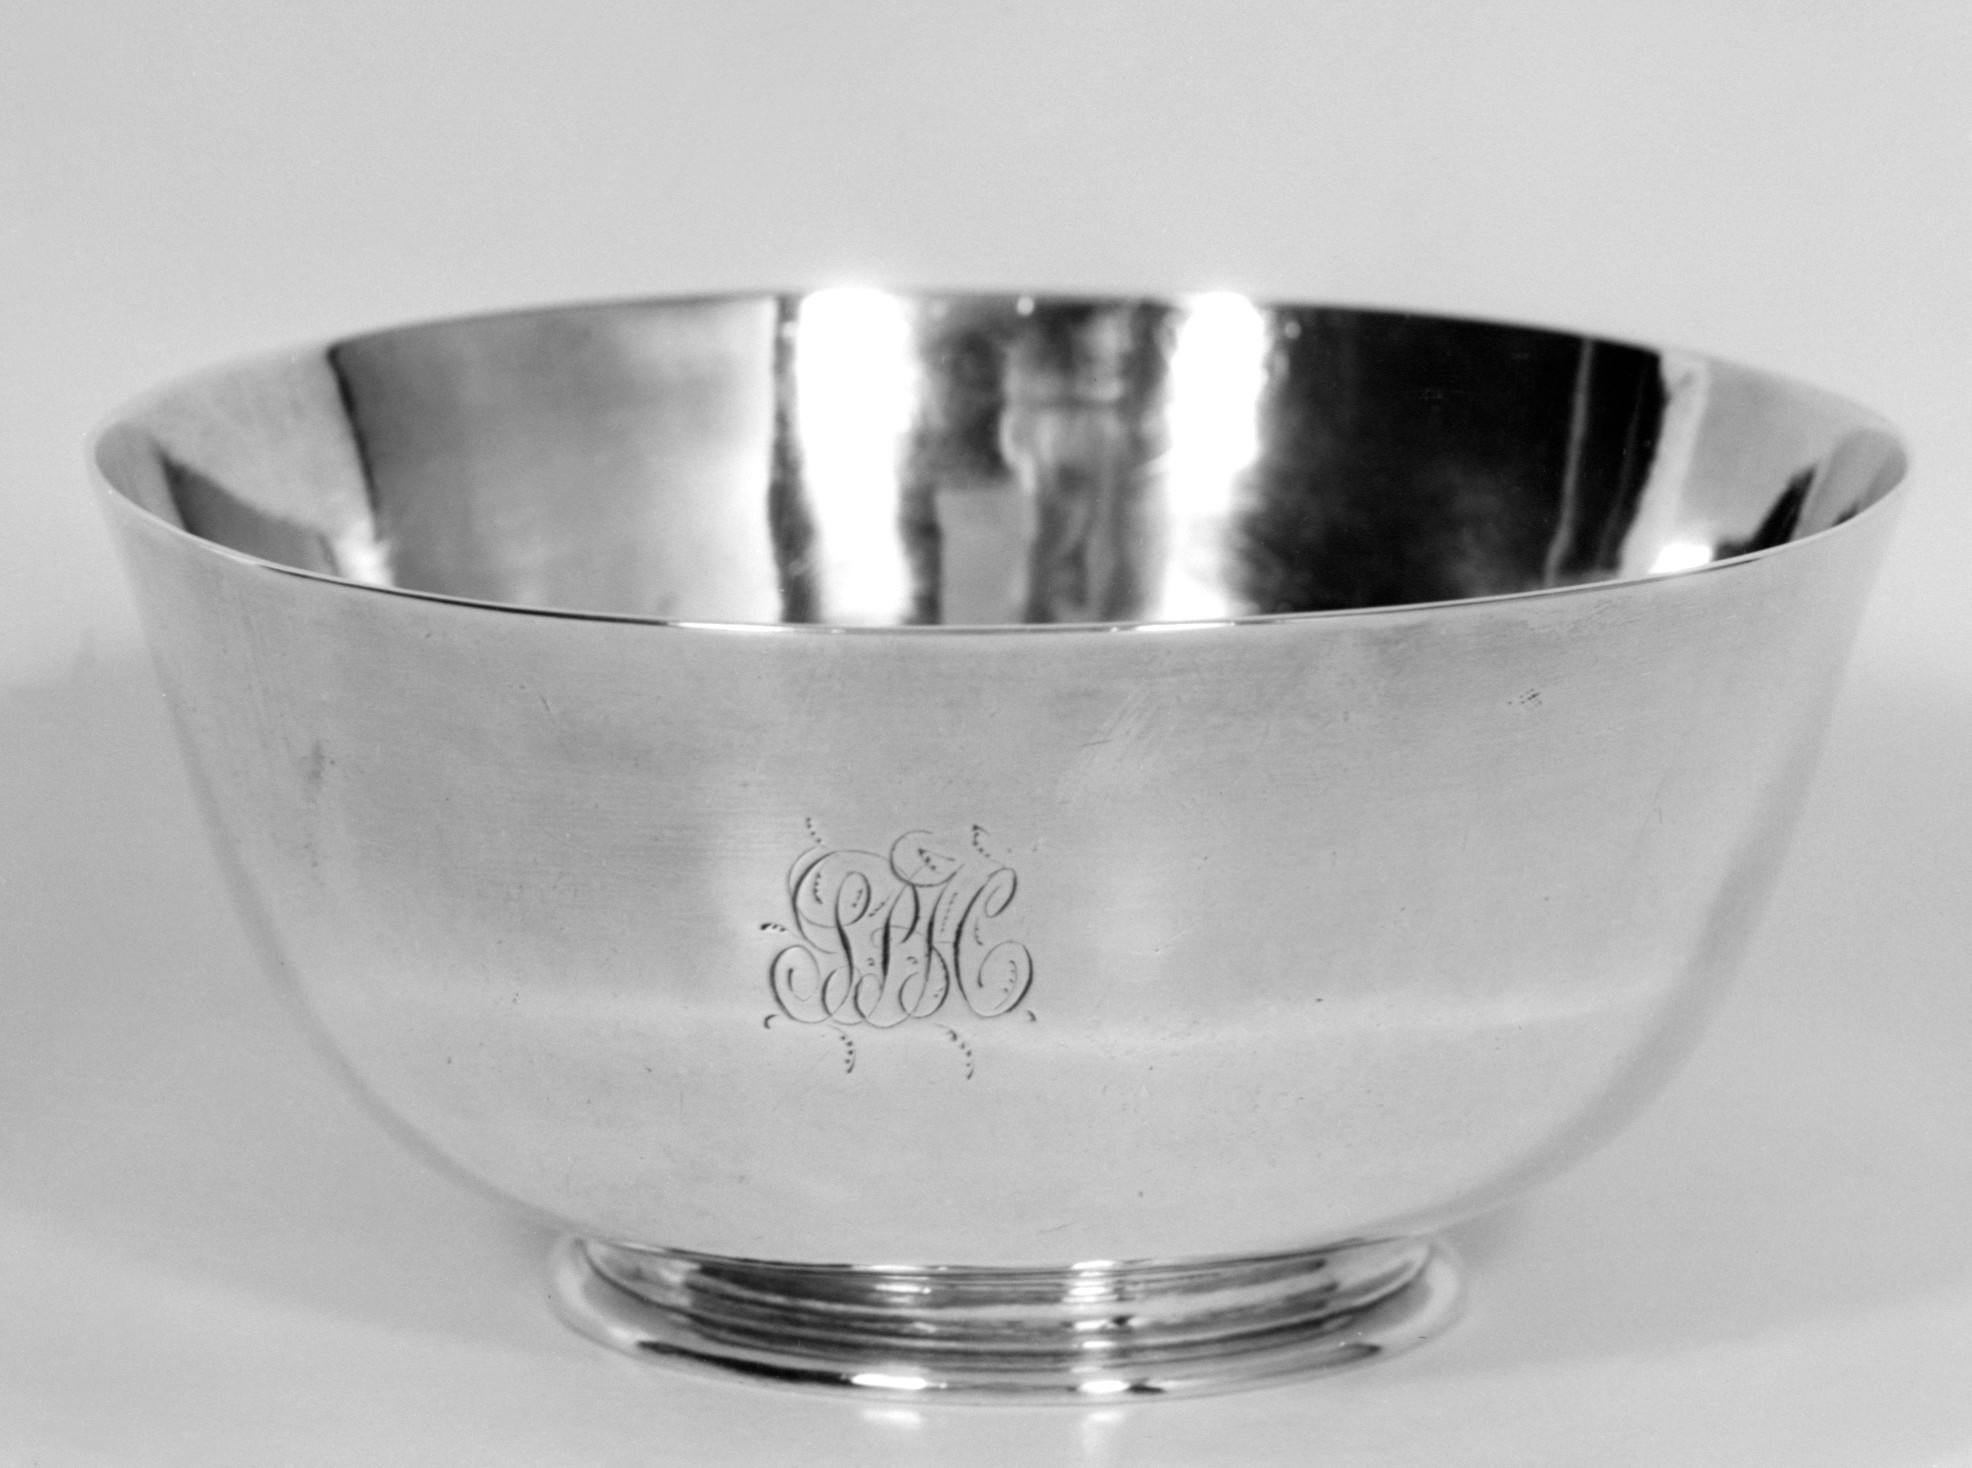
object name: bowl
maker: edward pocock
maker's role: maker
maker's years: 1728-1734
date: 1736-1737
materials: silver